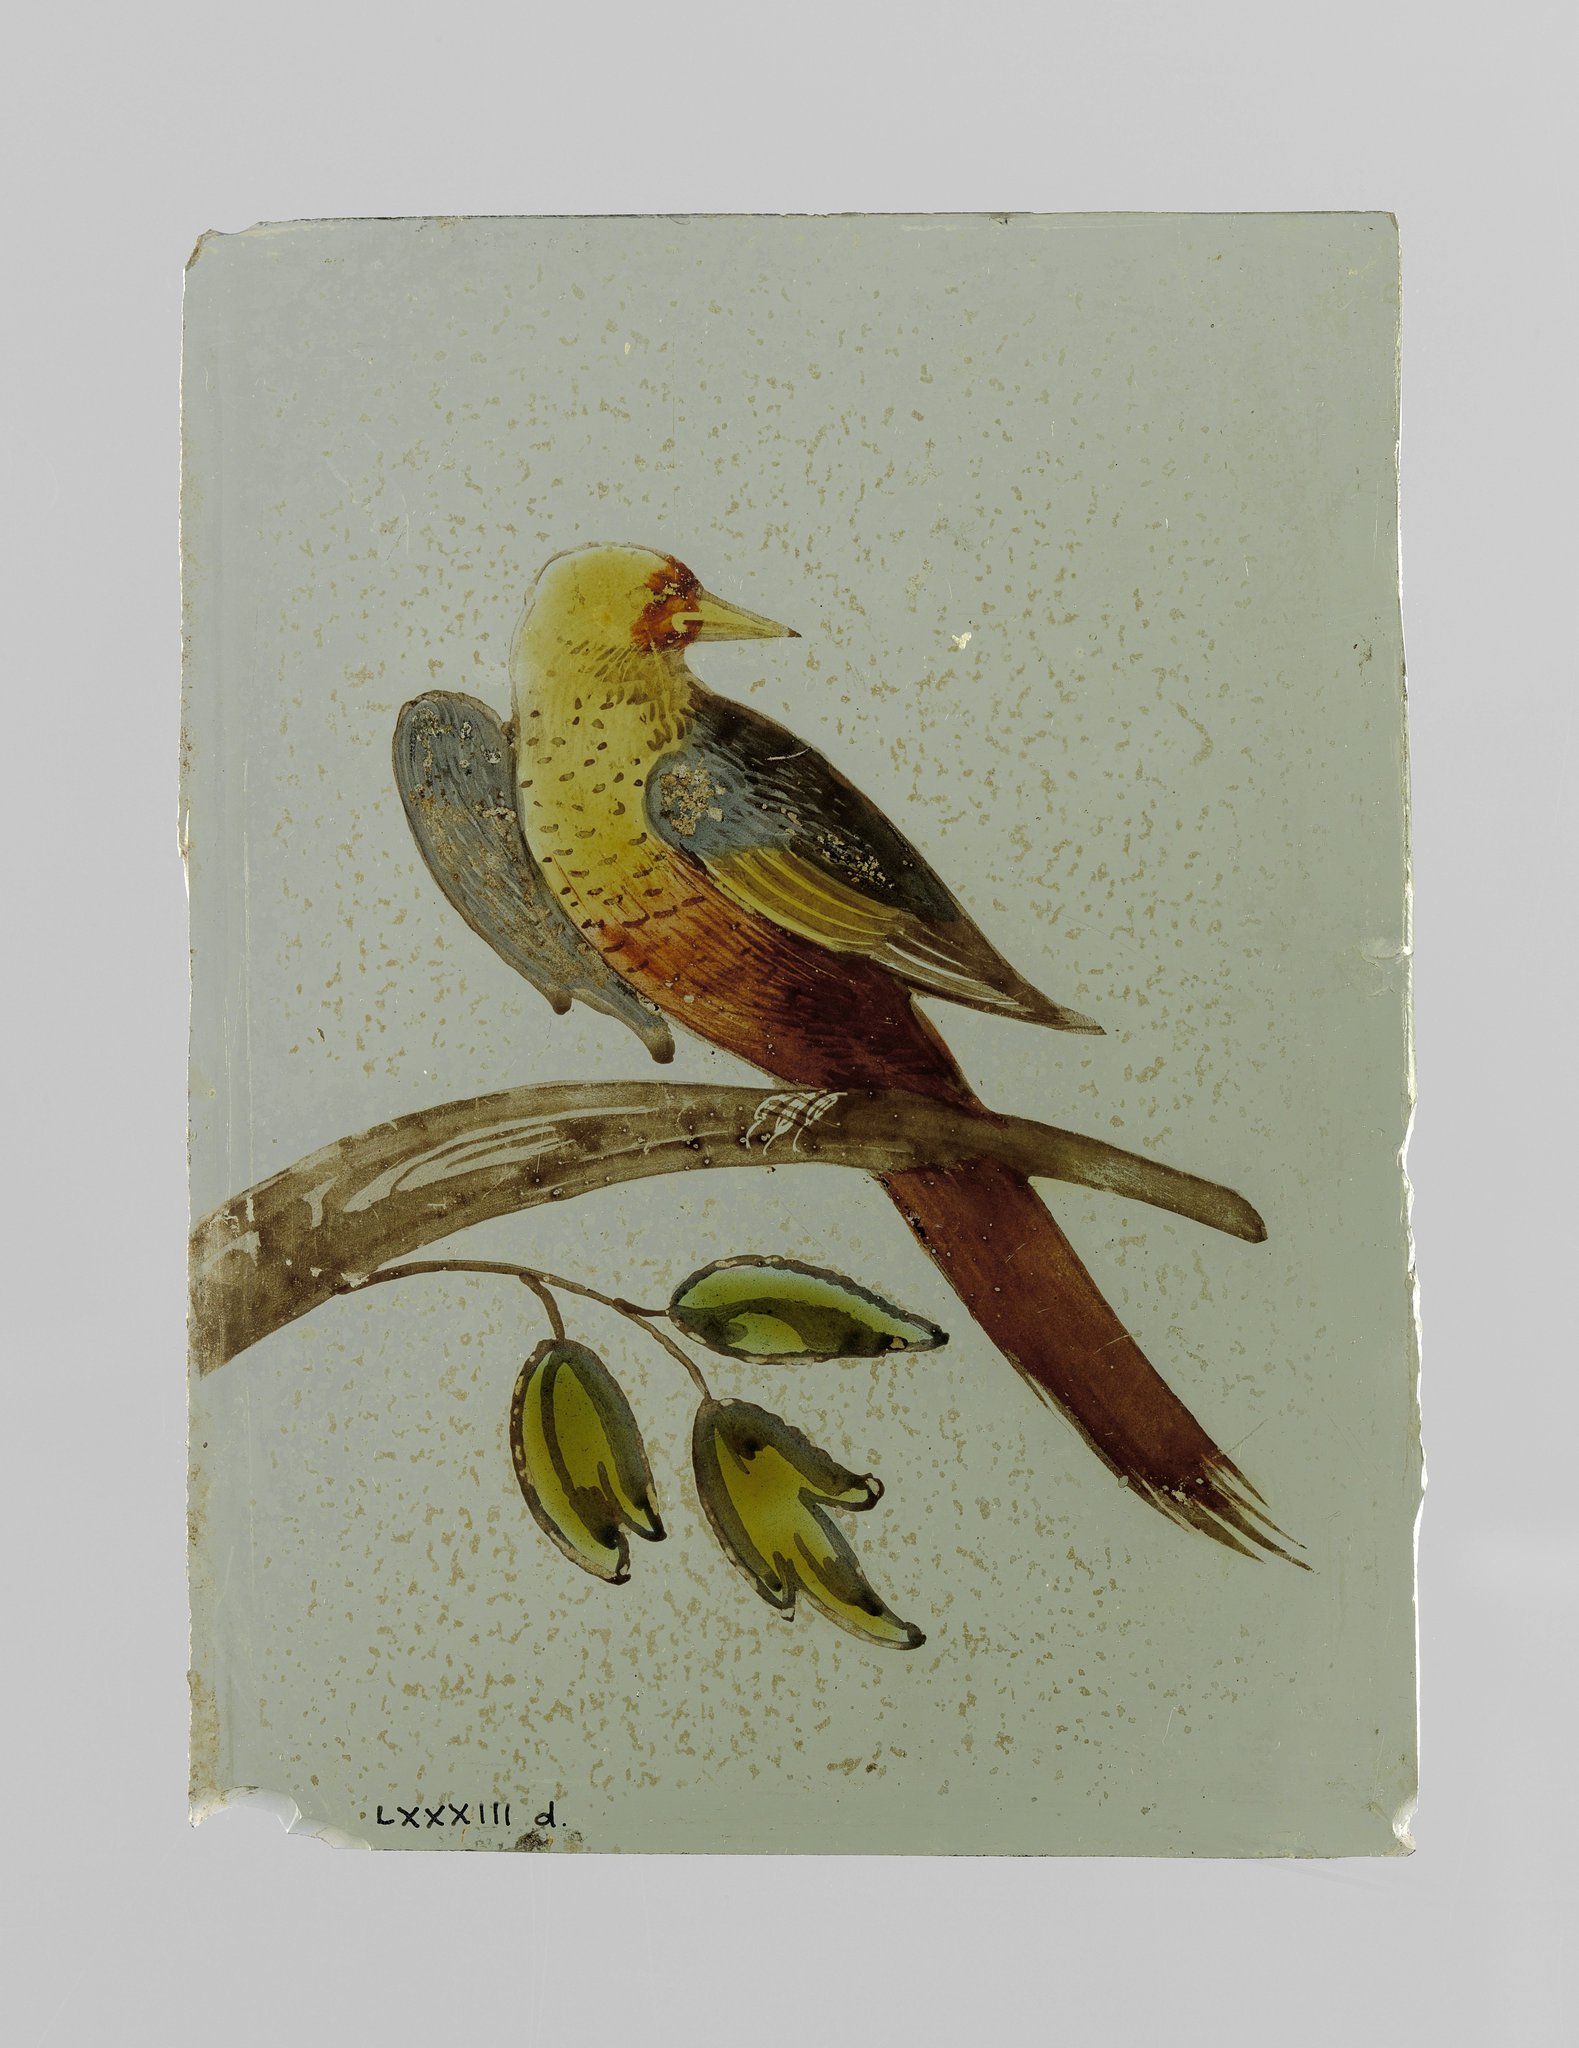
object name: light window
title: Ruit met een vogel op een tak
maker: Anonymous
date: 1650-1675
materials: glass, lead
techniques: enamel painting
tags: birds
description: Een ruit met emailschildering van een vogel op een tak in overwegend geel, blauw, rood en grisaille.